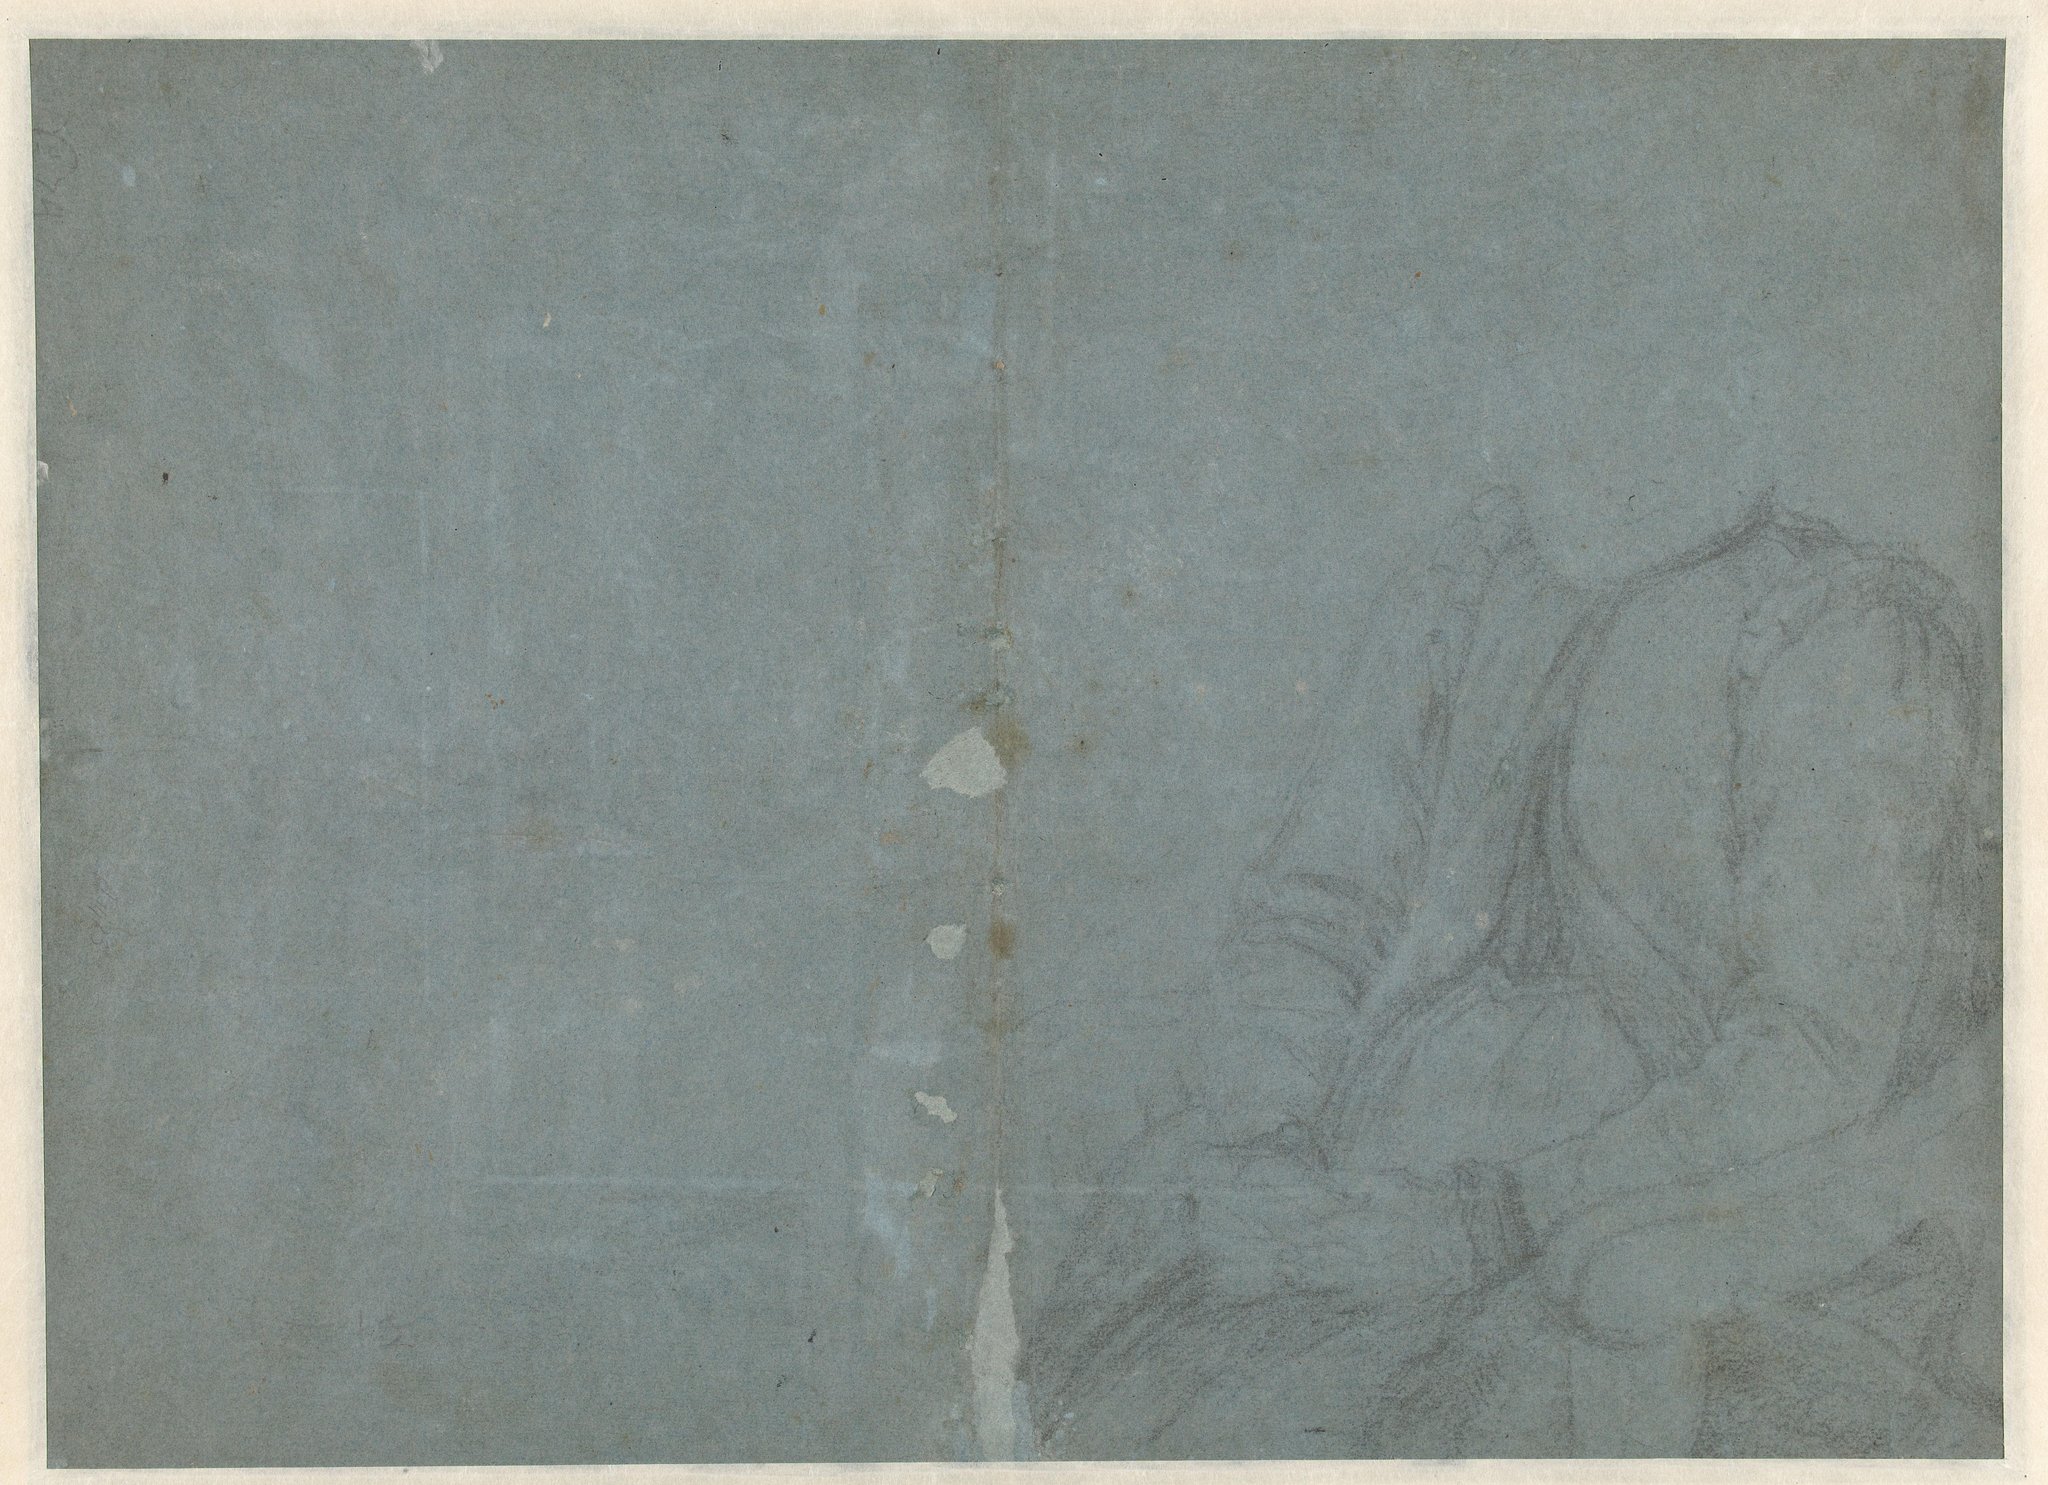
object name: drawing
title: Studie van een zittende vrouw, zonder hoofd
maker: cornelis ketel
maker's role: draughtsman, painter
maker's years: 1548-1616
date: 1589-1594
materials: chalk, paper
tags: sitting figure - aa - female human figure